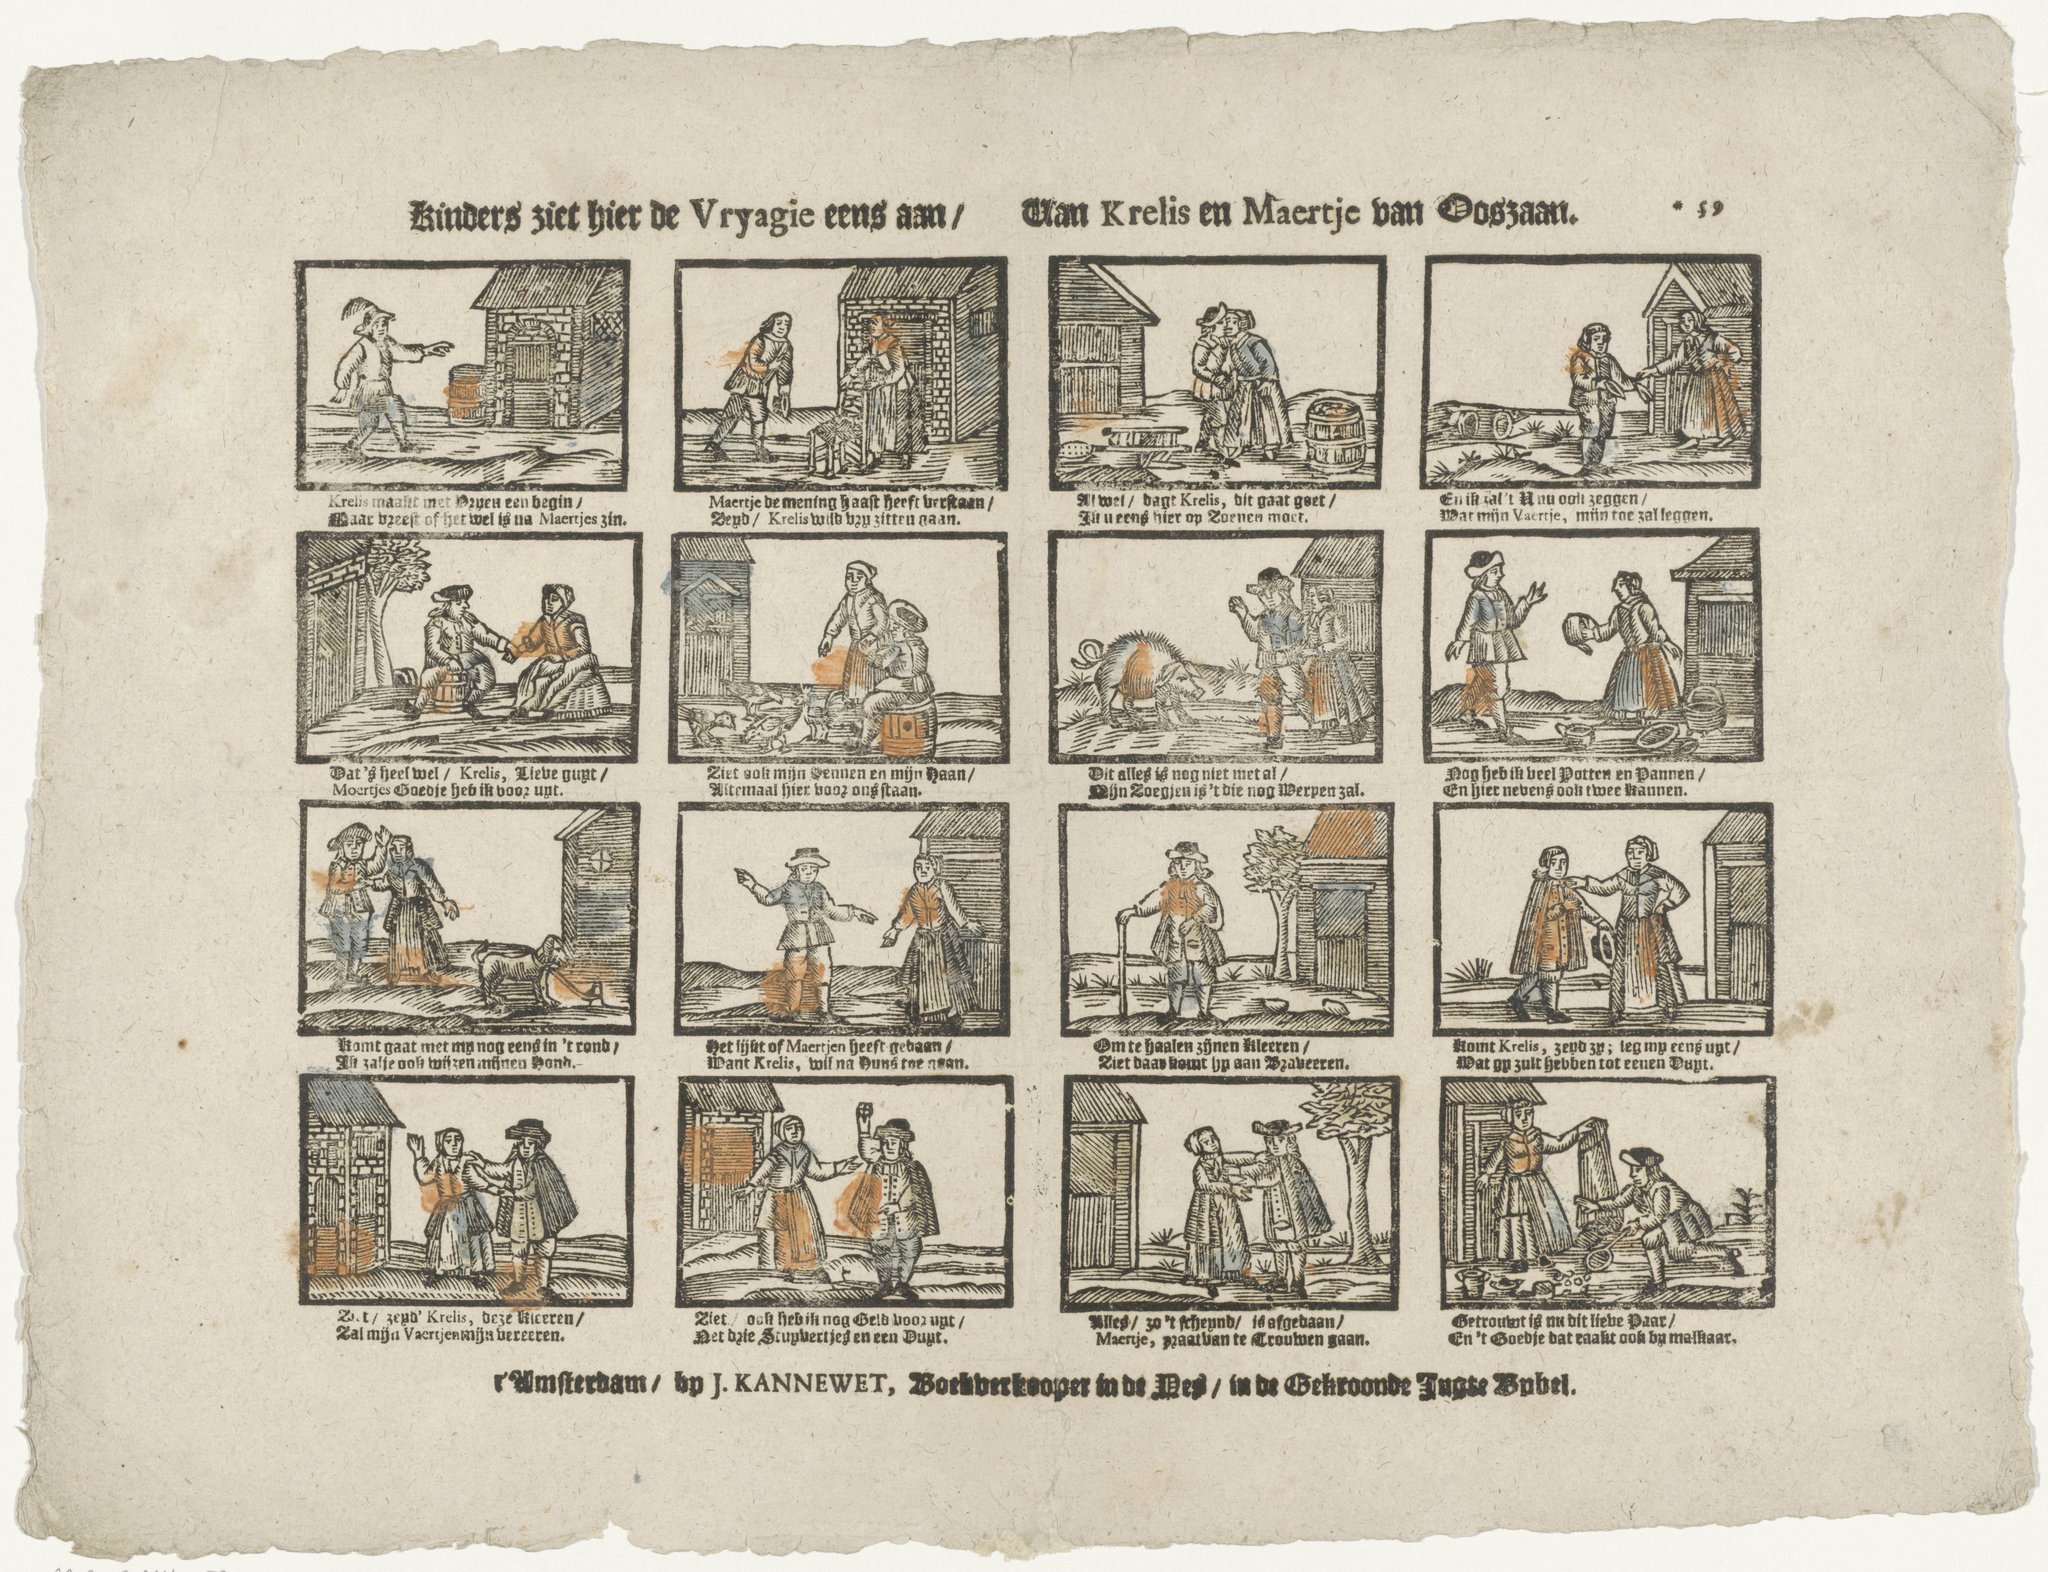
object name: popular print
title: Kinders ziet hier de vryagie eens aan / Van Krelis en Maertje van Oostzaan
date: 1725-1780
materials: paper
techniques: colour, letterpress printing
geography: amsterdam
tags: courting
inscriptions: collector's mark: Lugt 2760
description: Blad met 16 voorstellingen van de vrijage van de arme Krelis en Maartje van Oostzaan. Onder elke afbeelding een tweeregelig vers. Genummerd rechtsboven: *59.